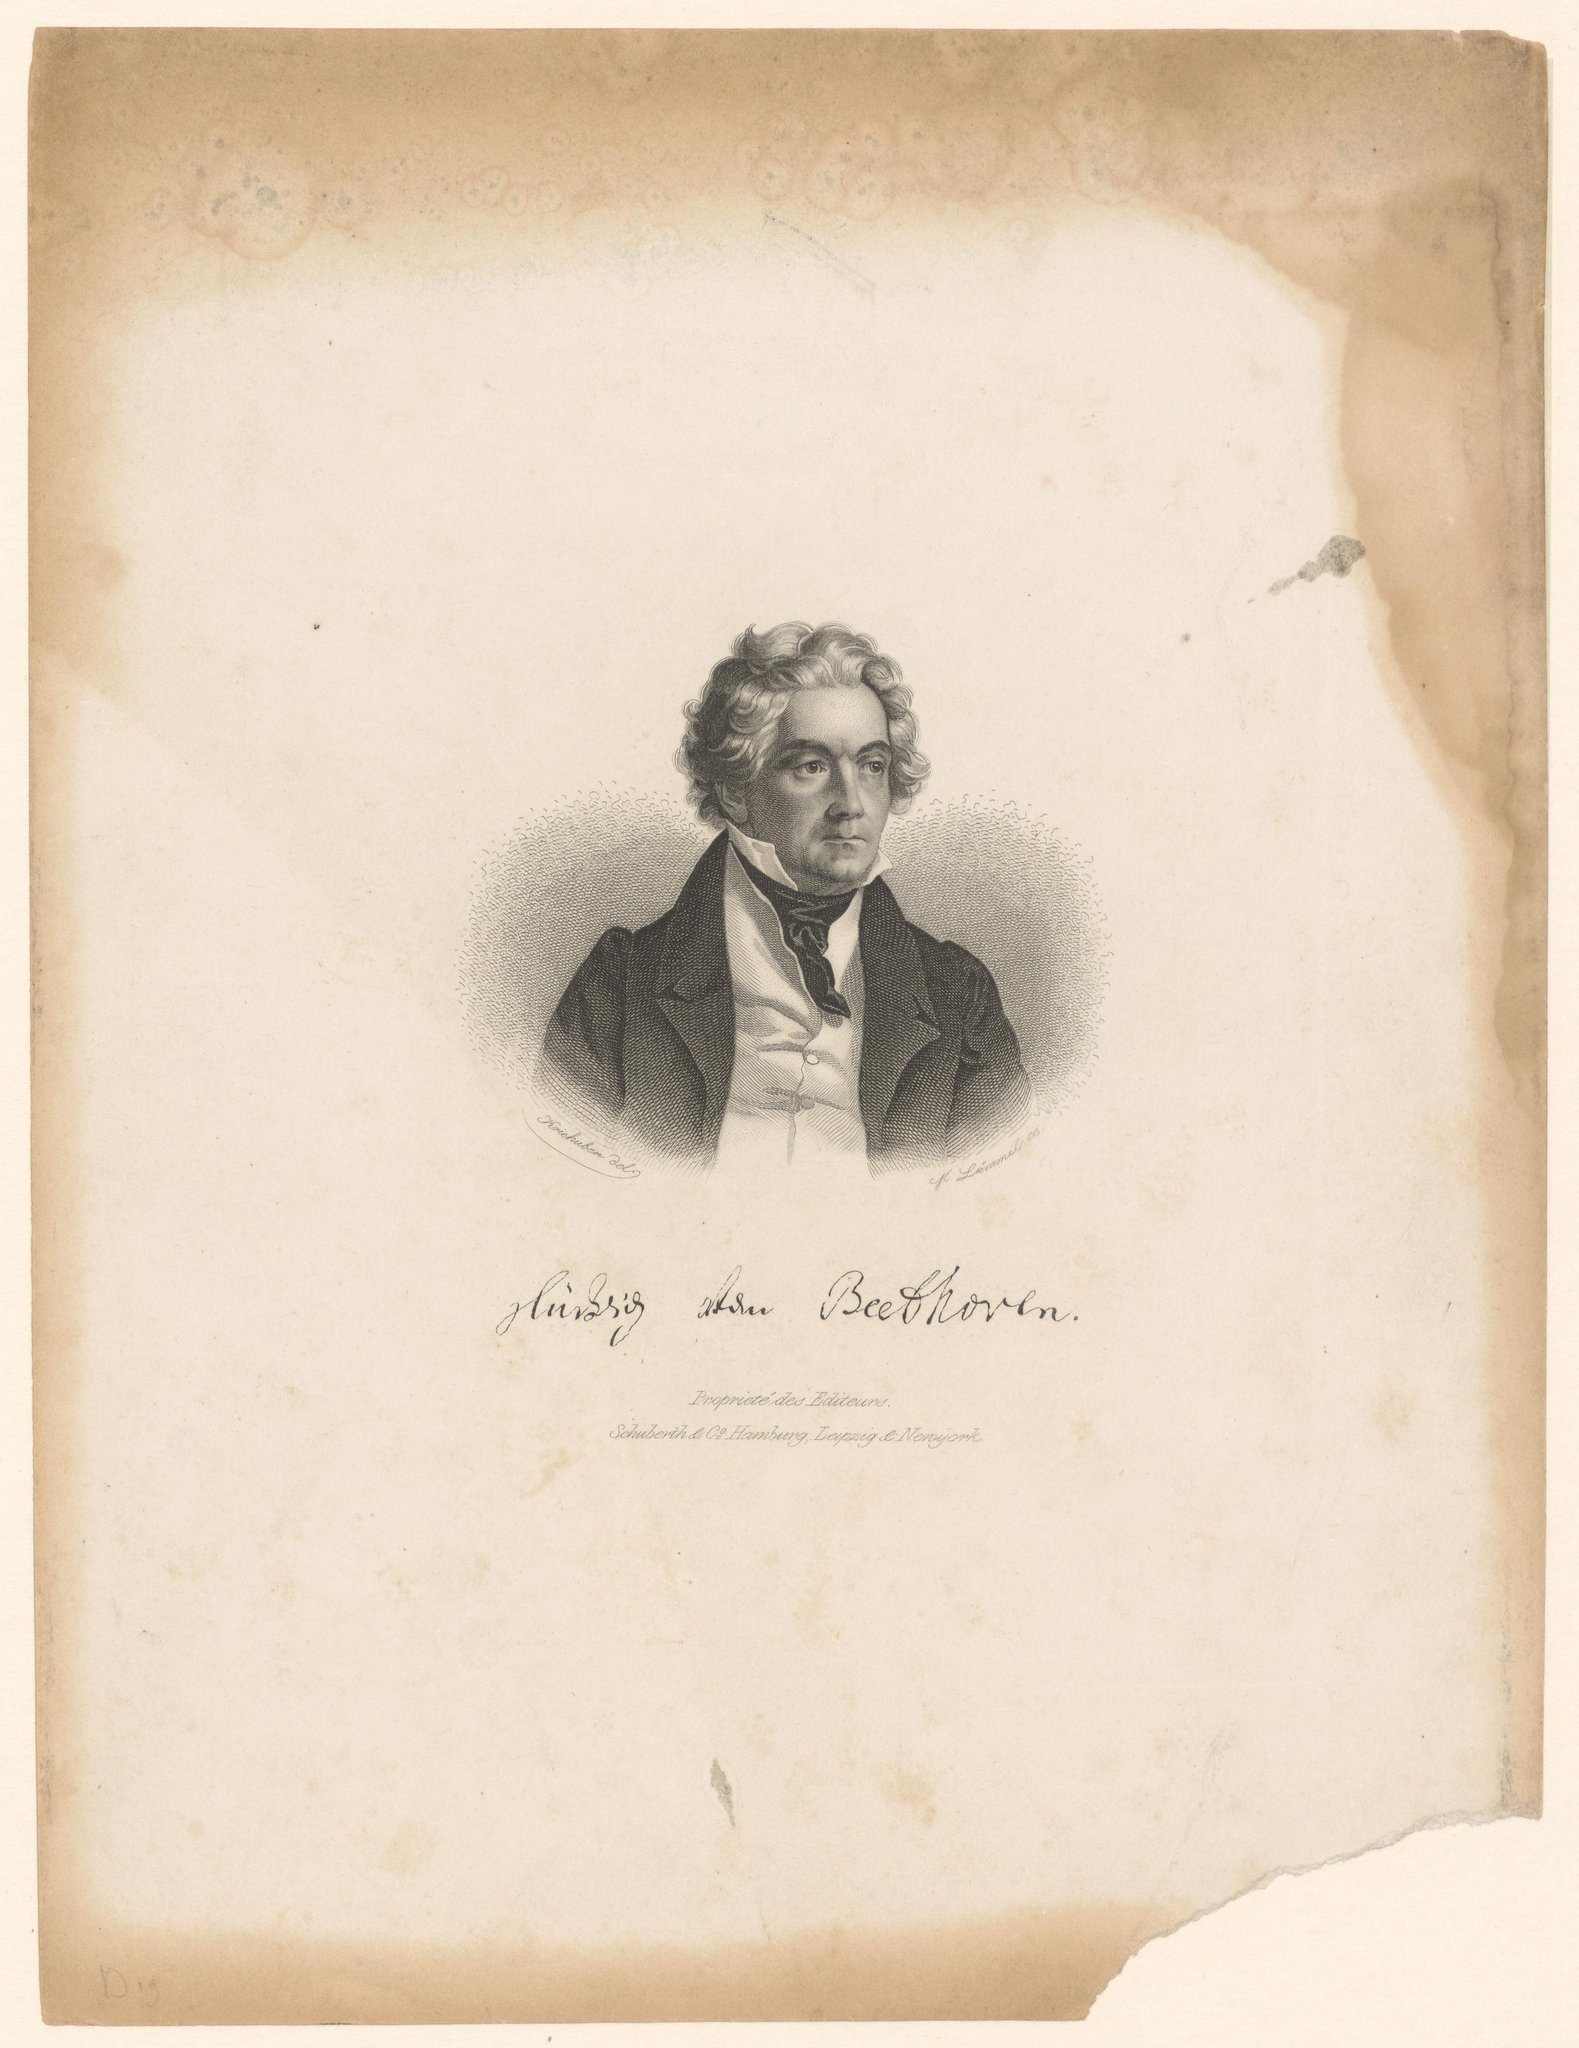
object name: print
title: Portret van Ludwig van Beethoven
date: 1850-1866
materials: paper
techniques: engraving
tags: vienna, historical persons, portrait of composer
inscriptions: collector's mark: Lugt 2228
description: Een facsimile signatuur in de ondermarge.